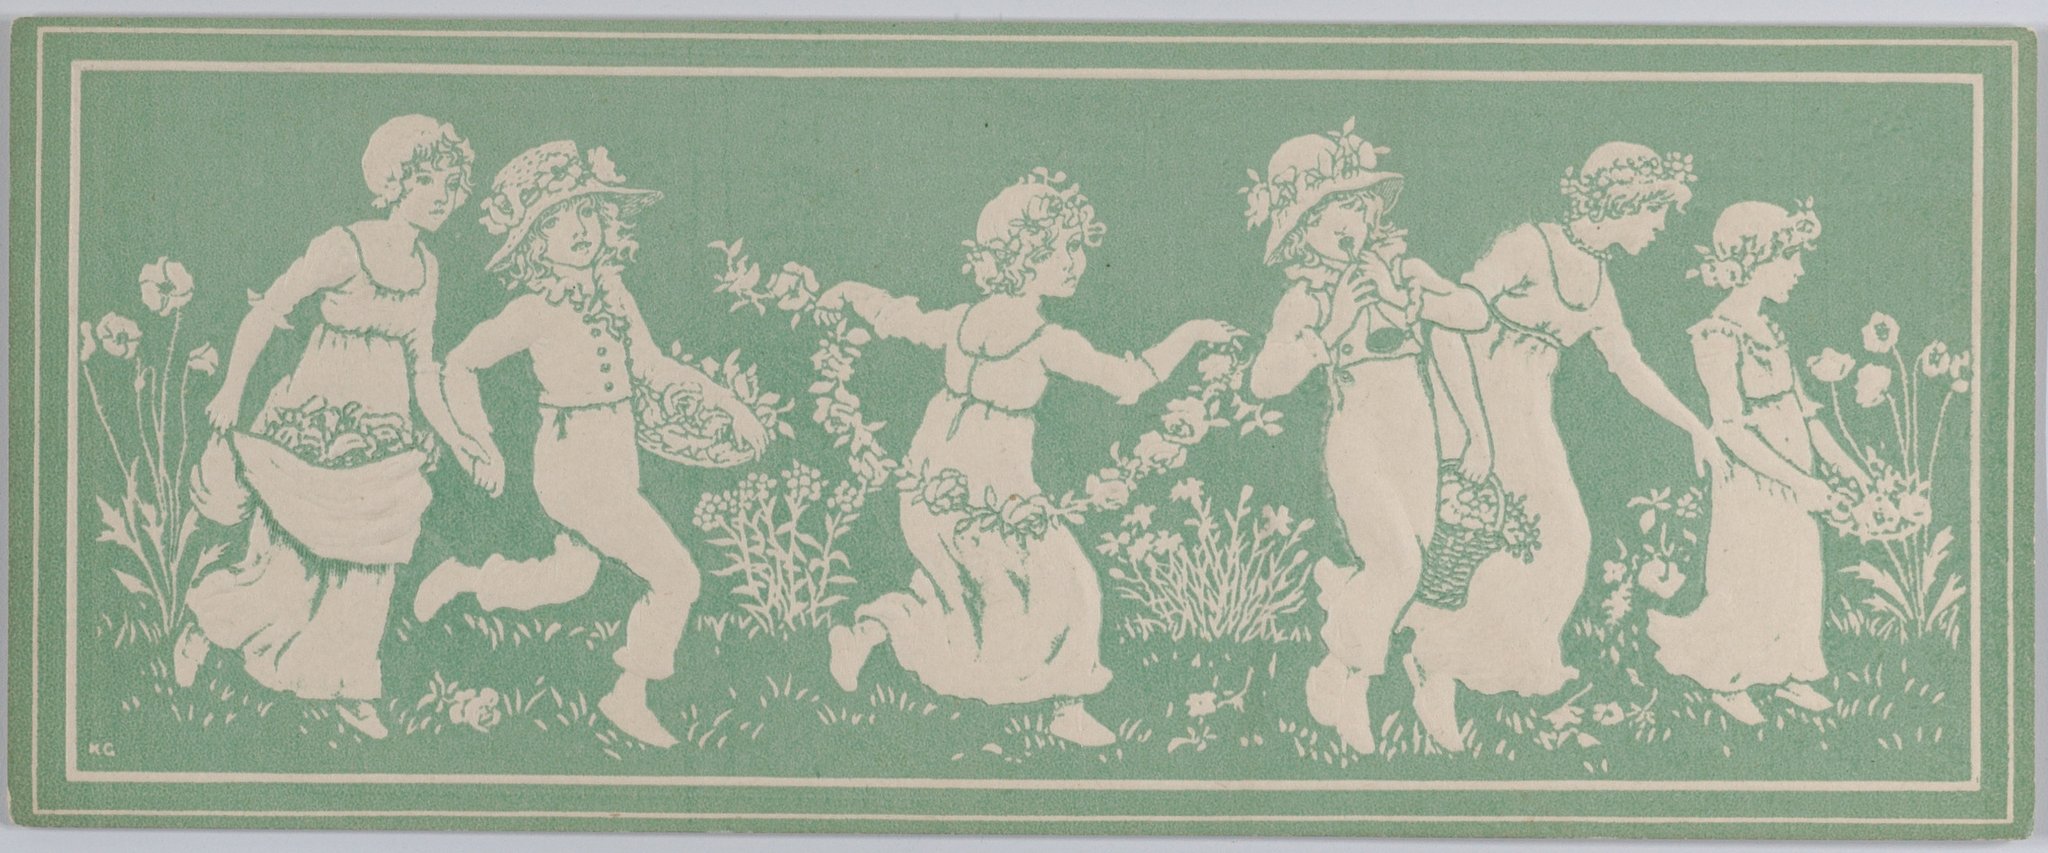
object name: valentine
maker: kate greenaway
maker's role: artist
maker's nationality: british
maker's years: 1846-1901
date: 1880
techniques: printing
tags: boys,girls